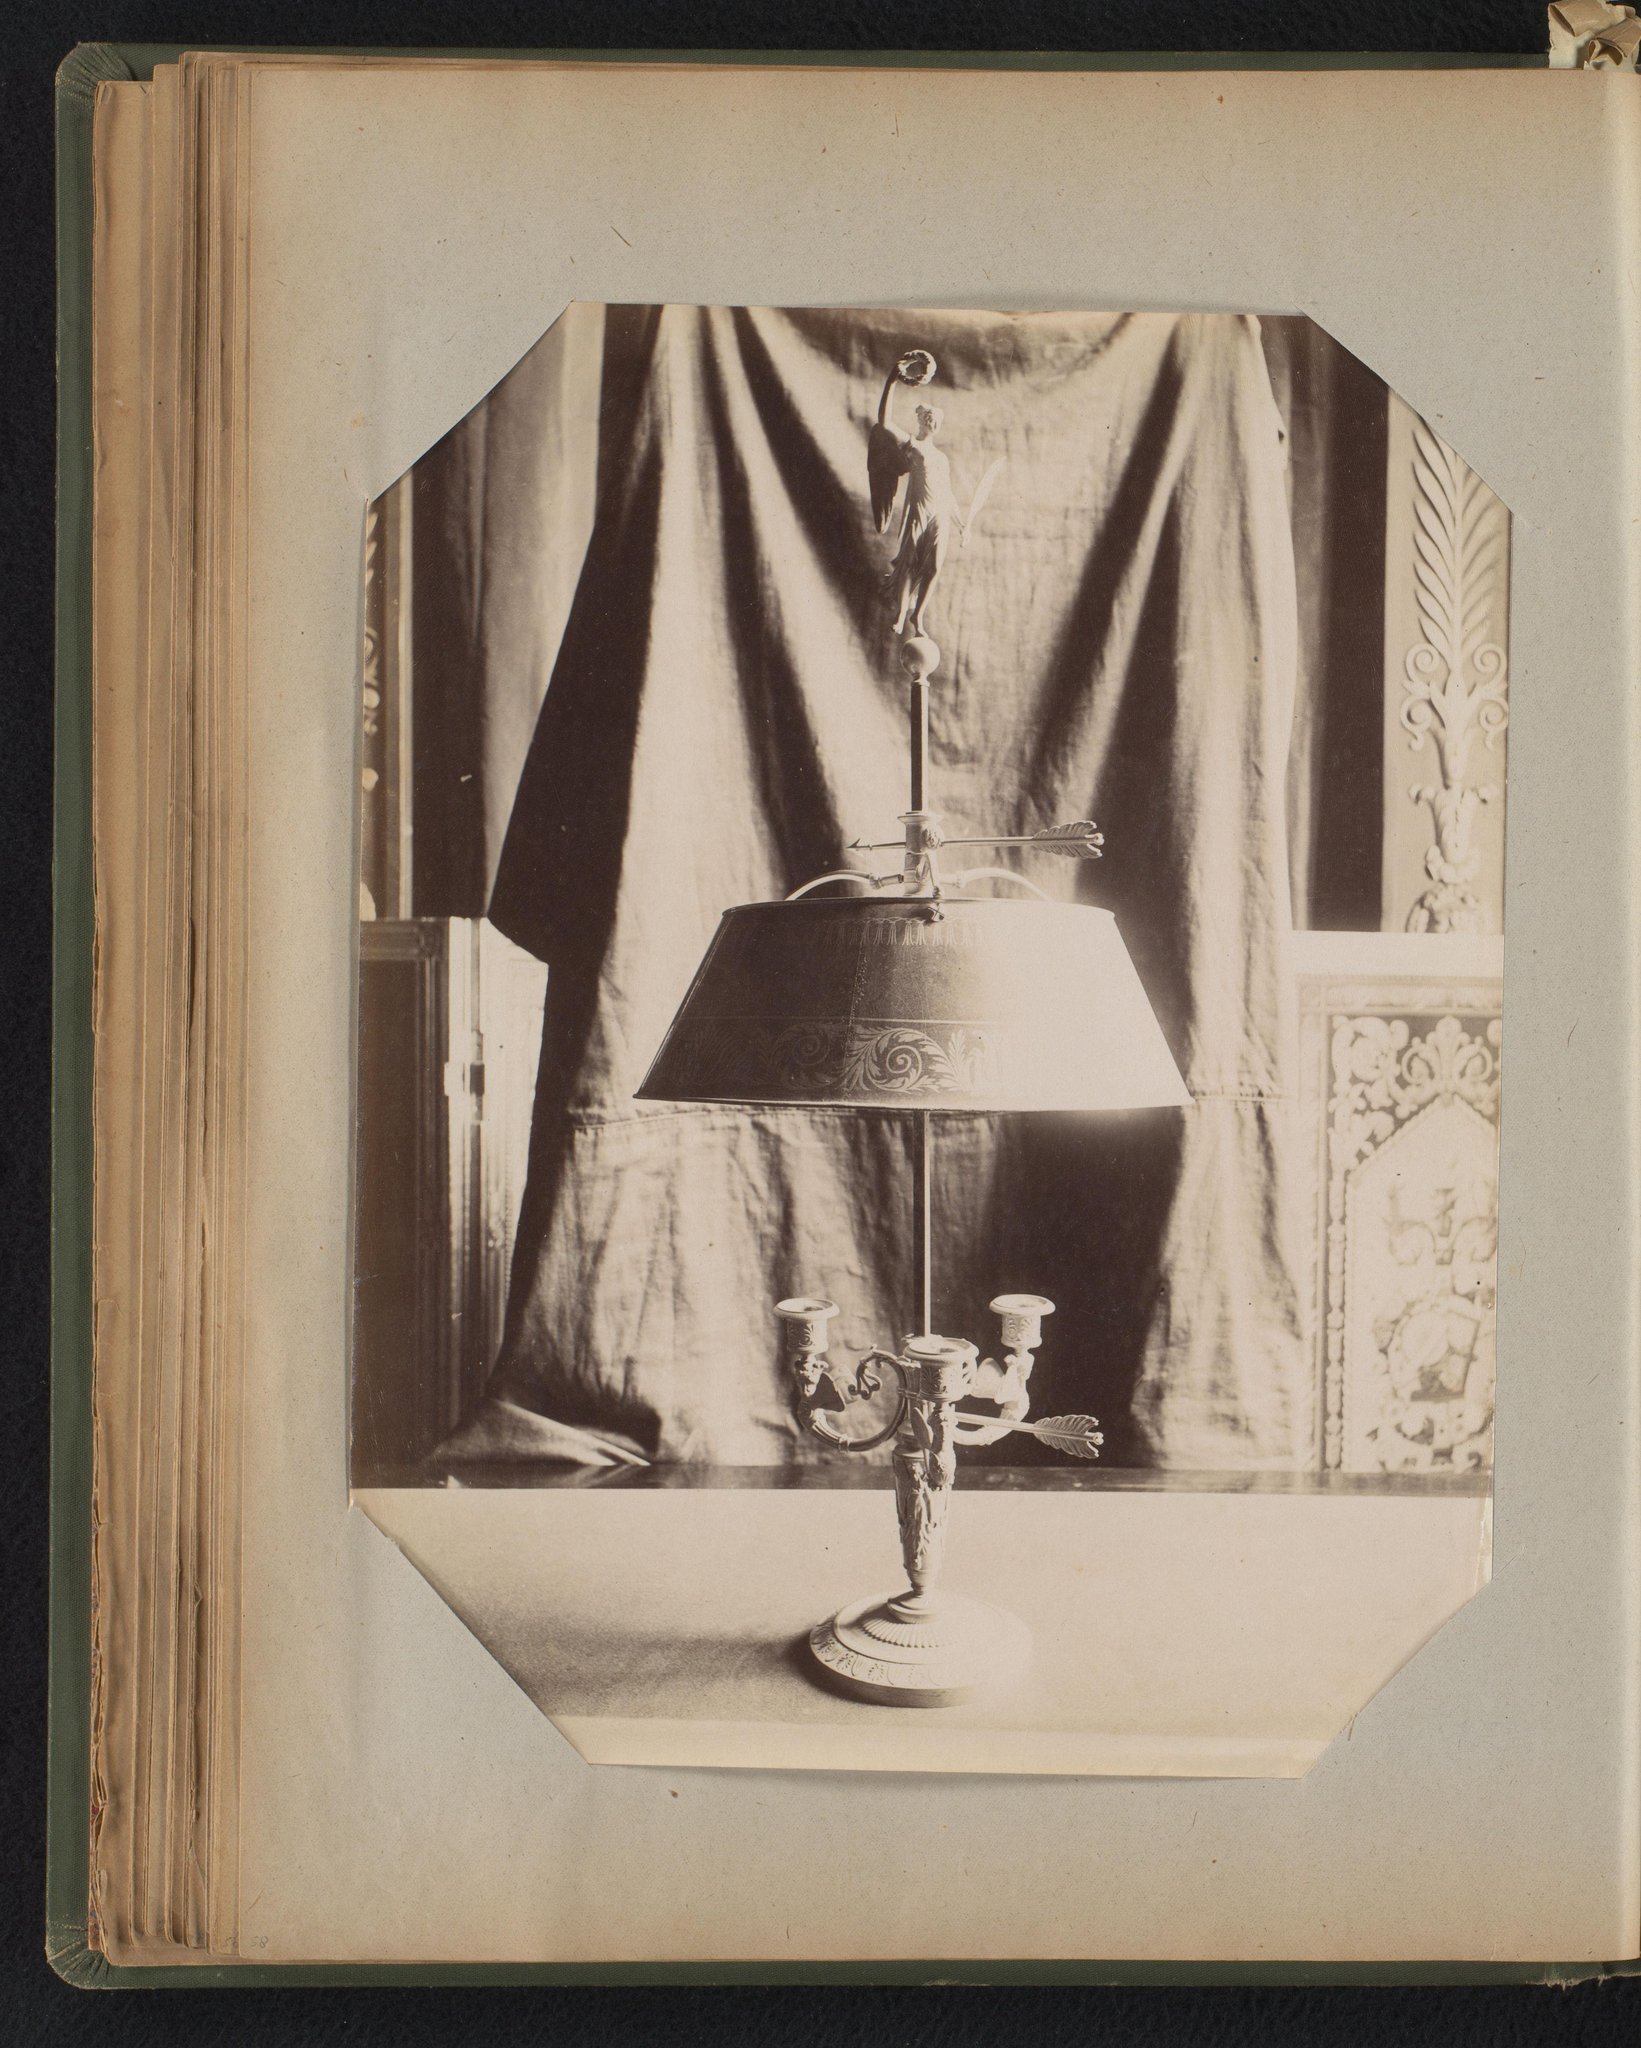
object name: photograph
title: Driearmige bronzen kandelaar afgedekt met een kap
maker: Anonymous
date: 1860-1900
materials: paper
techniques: albumen print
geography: france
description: Kandelaar is gedecoreerd met twee pijlen en bovenop een vrouwelijk gestalte met vleugels en lauwerkrans. Onderdeel van een serie met betrekking tot het interieur van het paleis van Versailles met kroonluchters, deuren, portalen en meubelstukken.